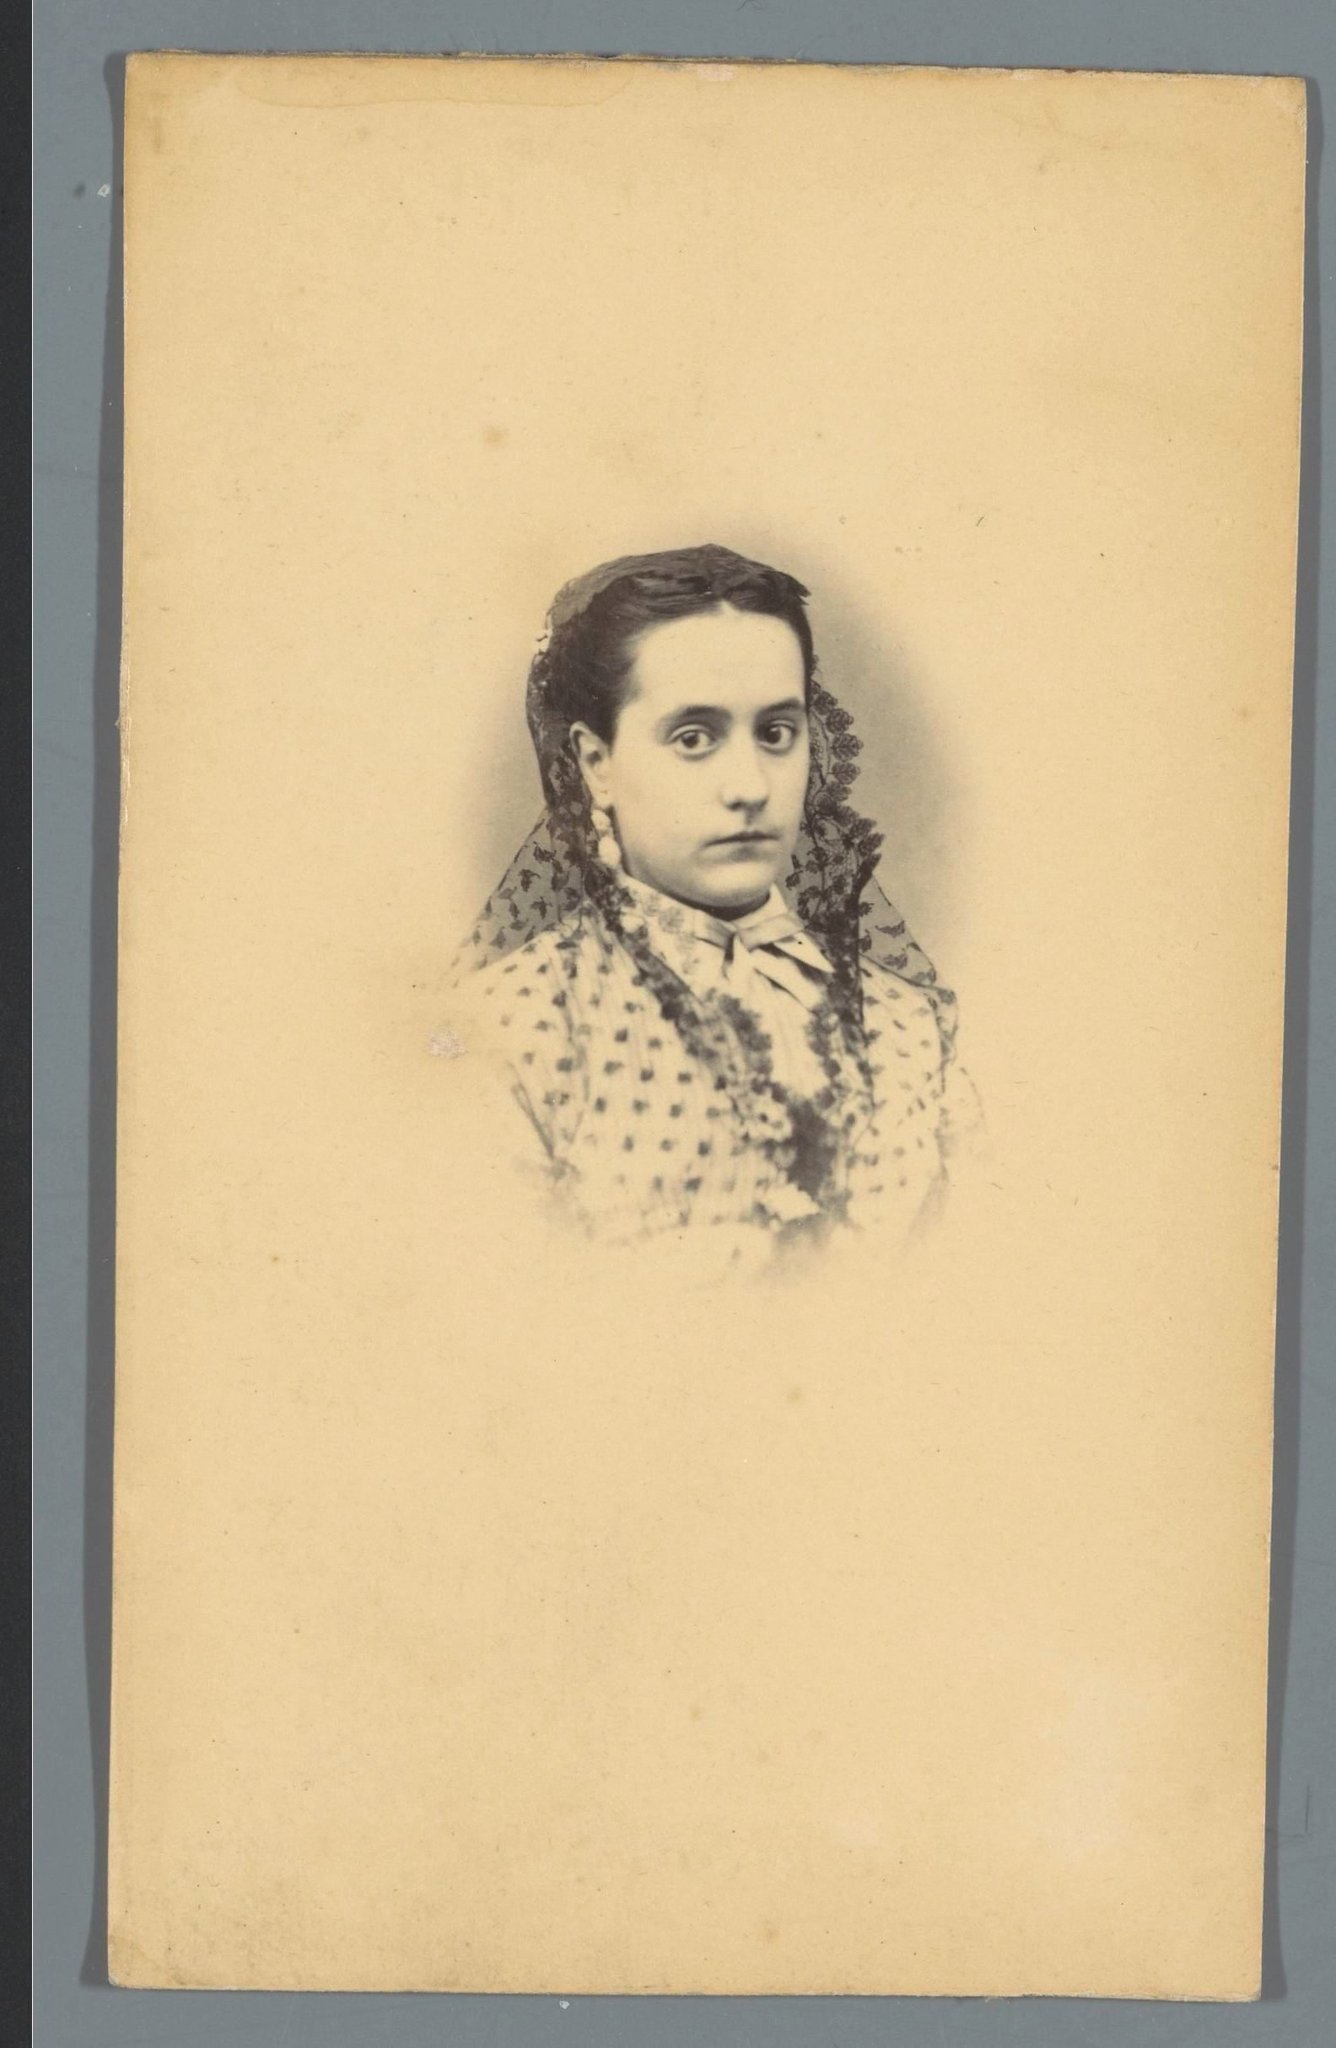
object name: carte de visite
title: Portret van een onbekende vrouw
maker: josé maría cordeiro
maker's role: fotograaf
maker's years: 1835-1917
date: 1855-1885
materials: cardboard, paper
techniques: albumen print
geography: madrid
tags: historical persons - bb - woman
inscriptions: inscription: ‘REAL PRIVILEGIO/ Puerta del Sol 13./ Madrid./ J M. CORDEIRO.’